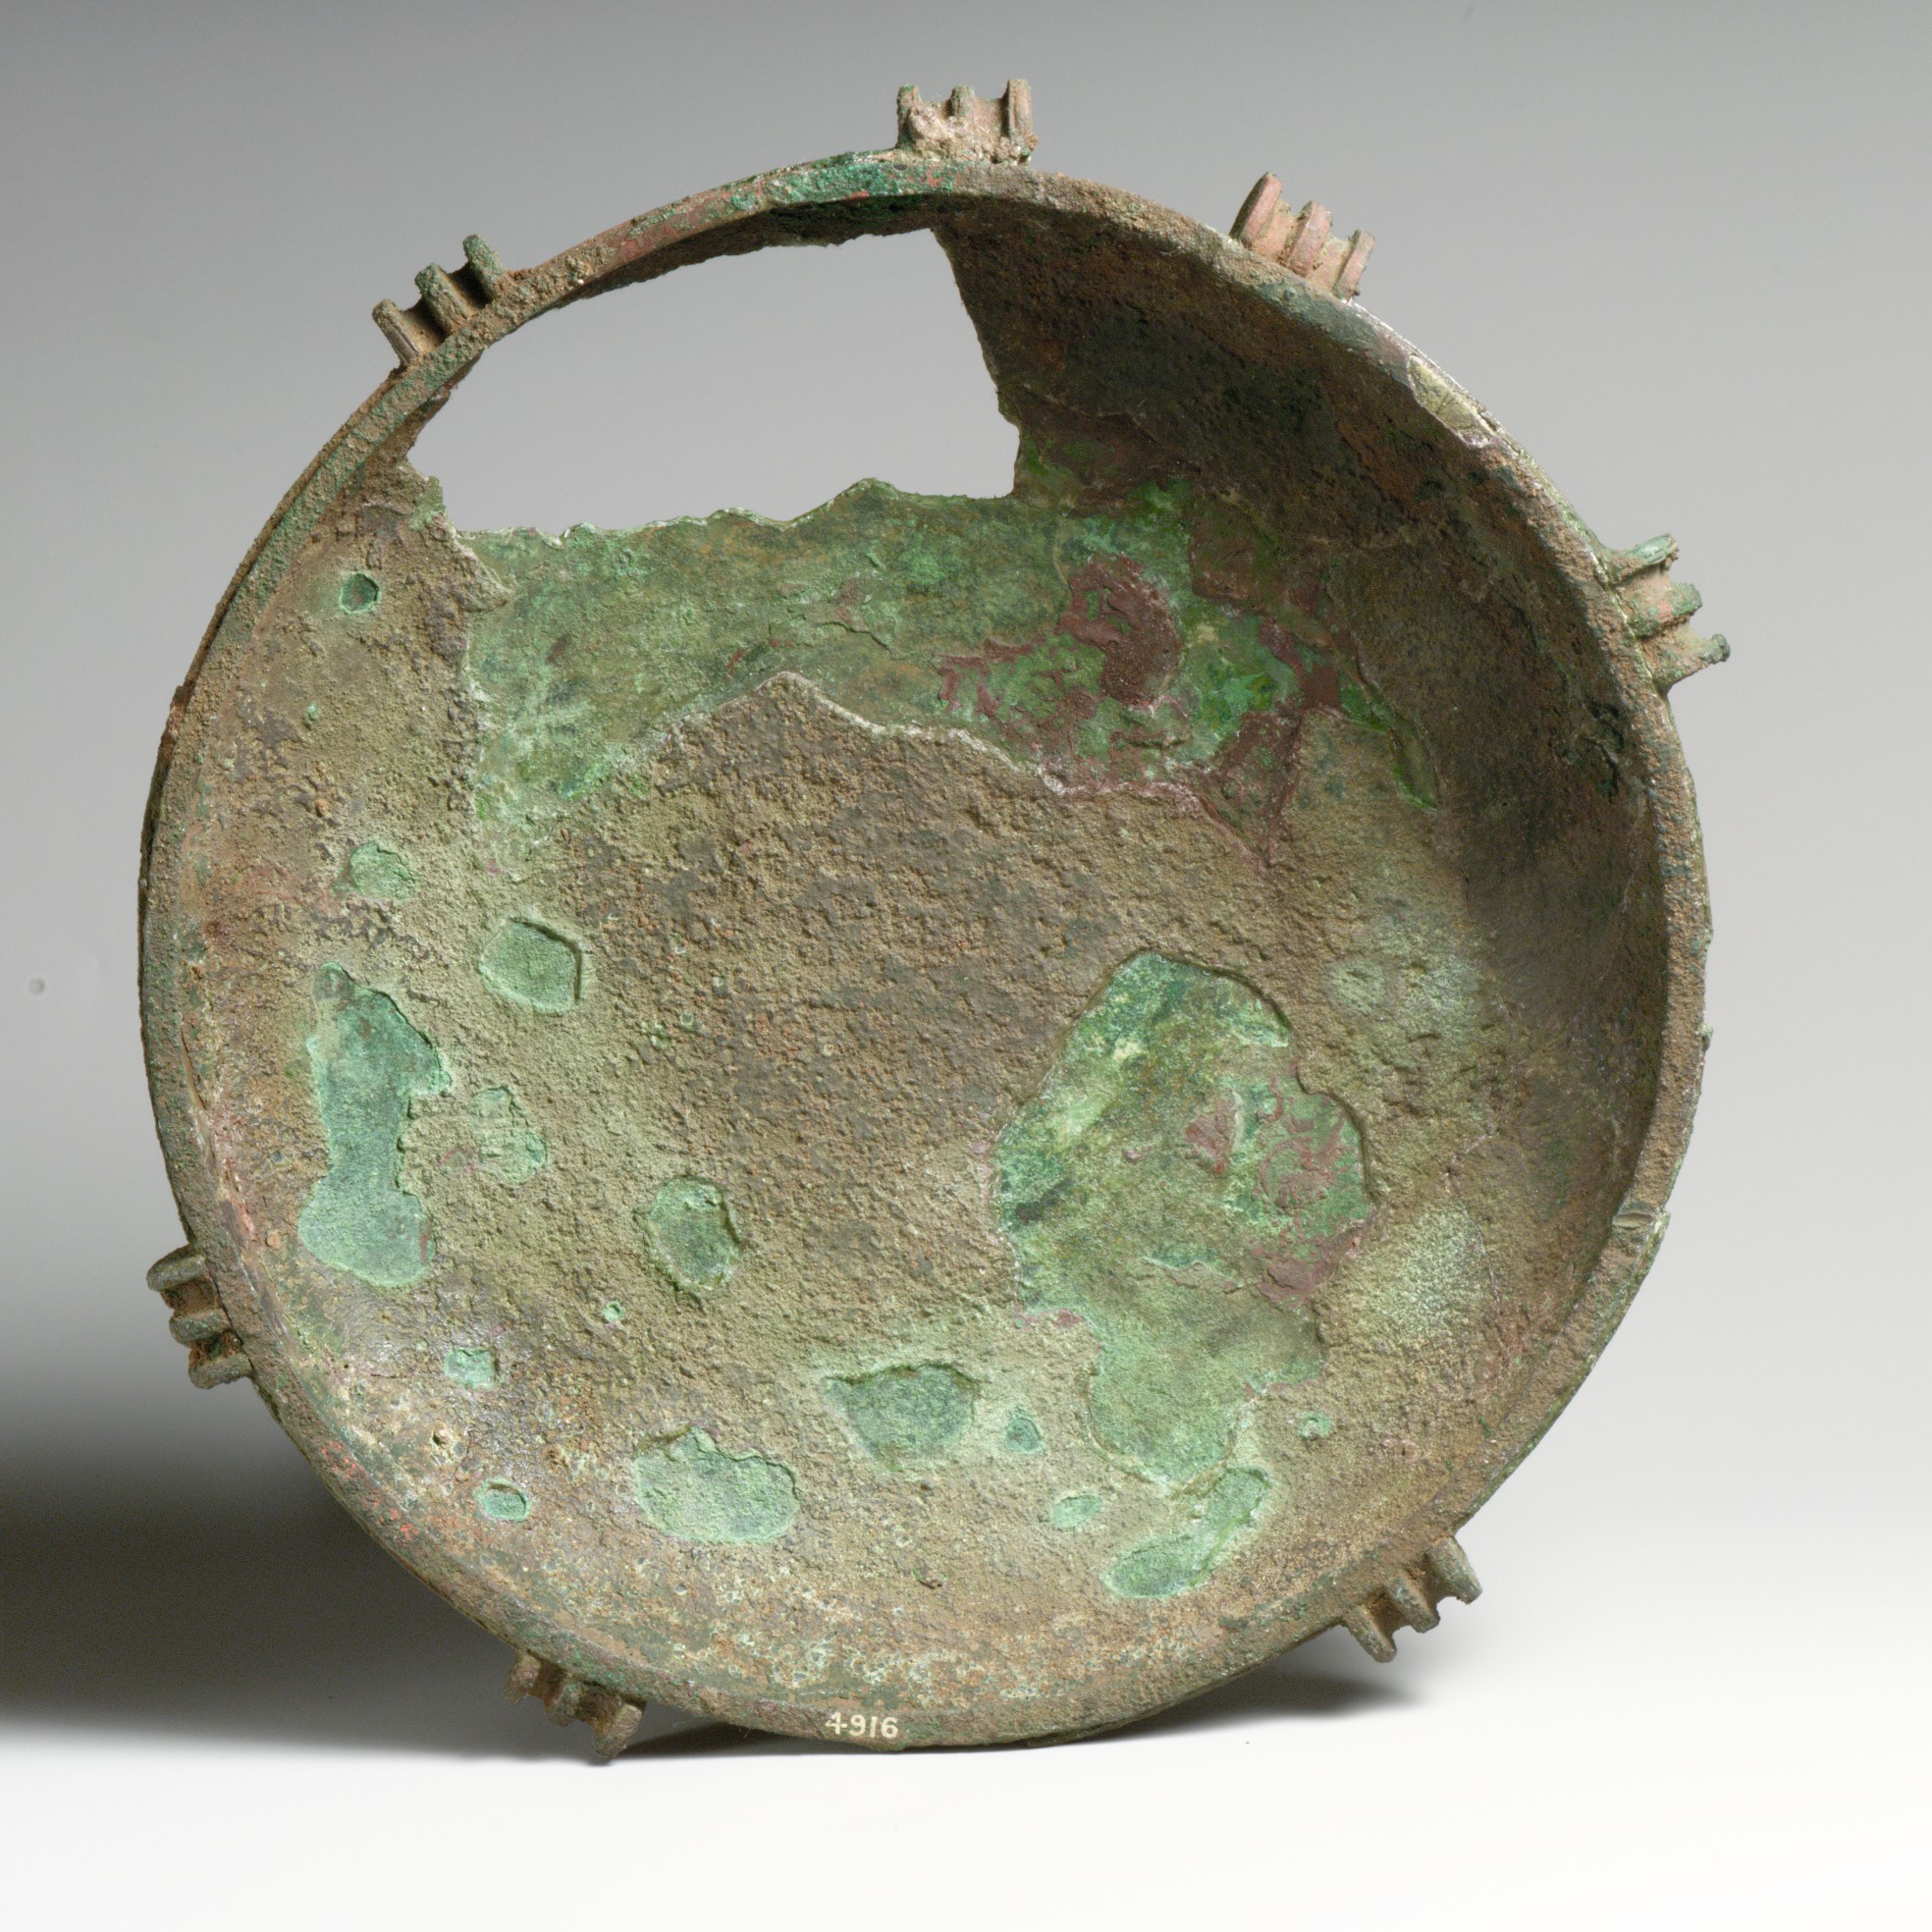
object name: bowl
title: Shallow bronze bowl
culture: cypriot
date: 700-501 BCE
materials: bronze